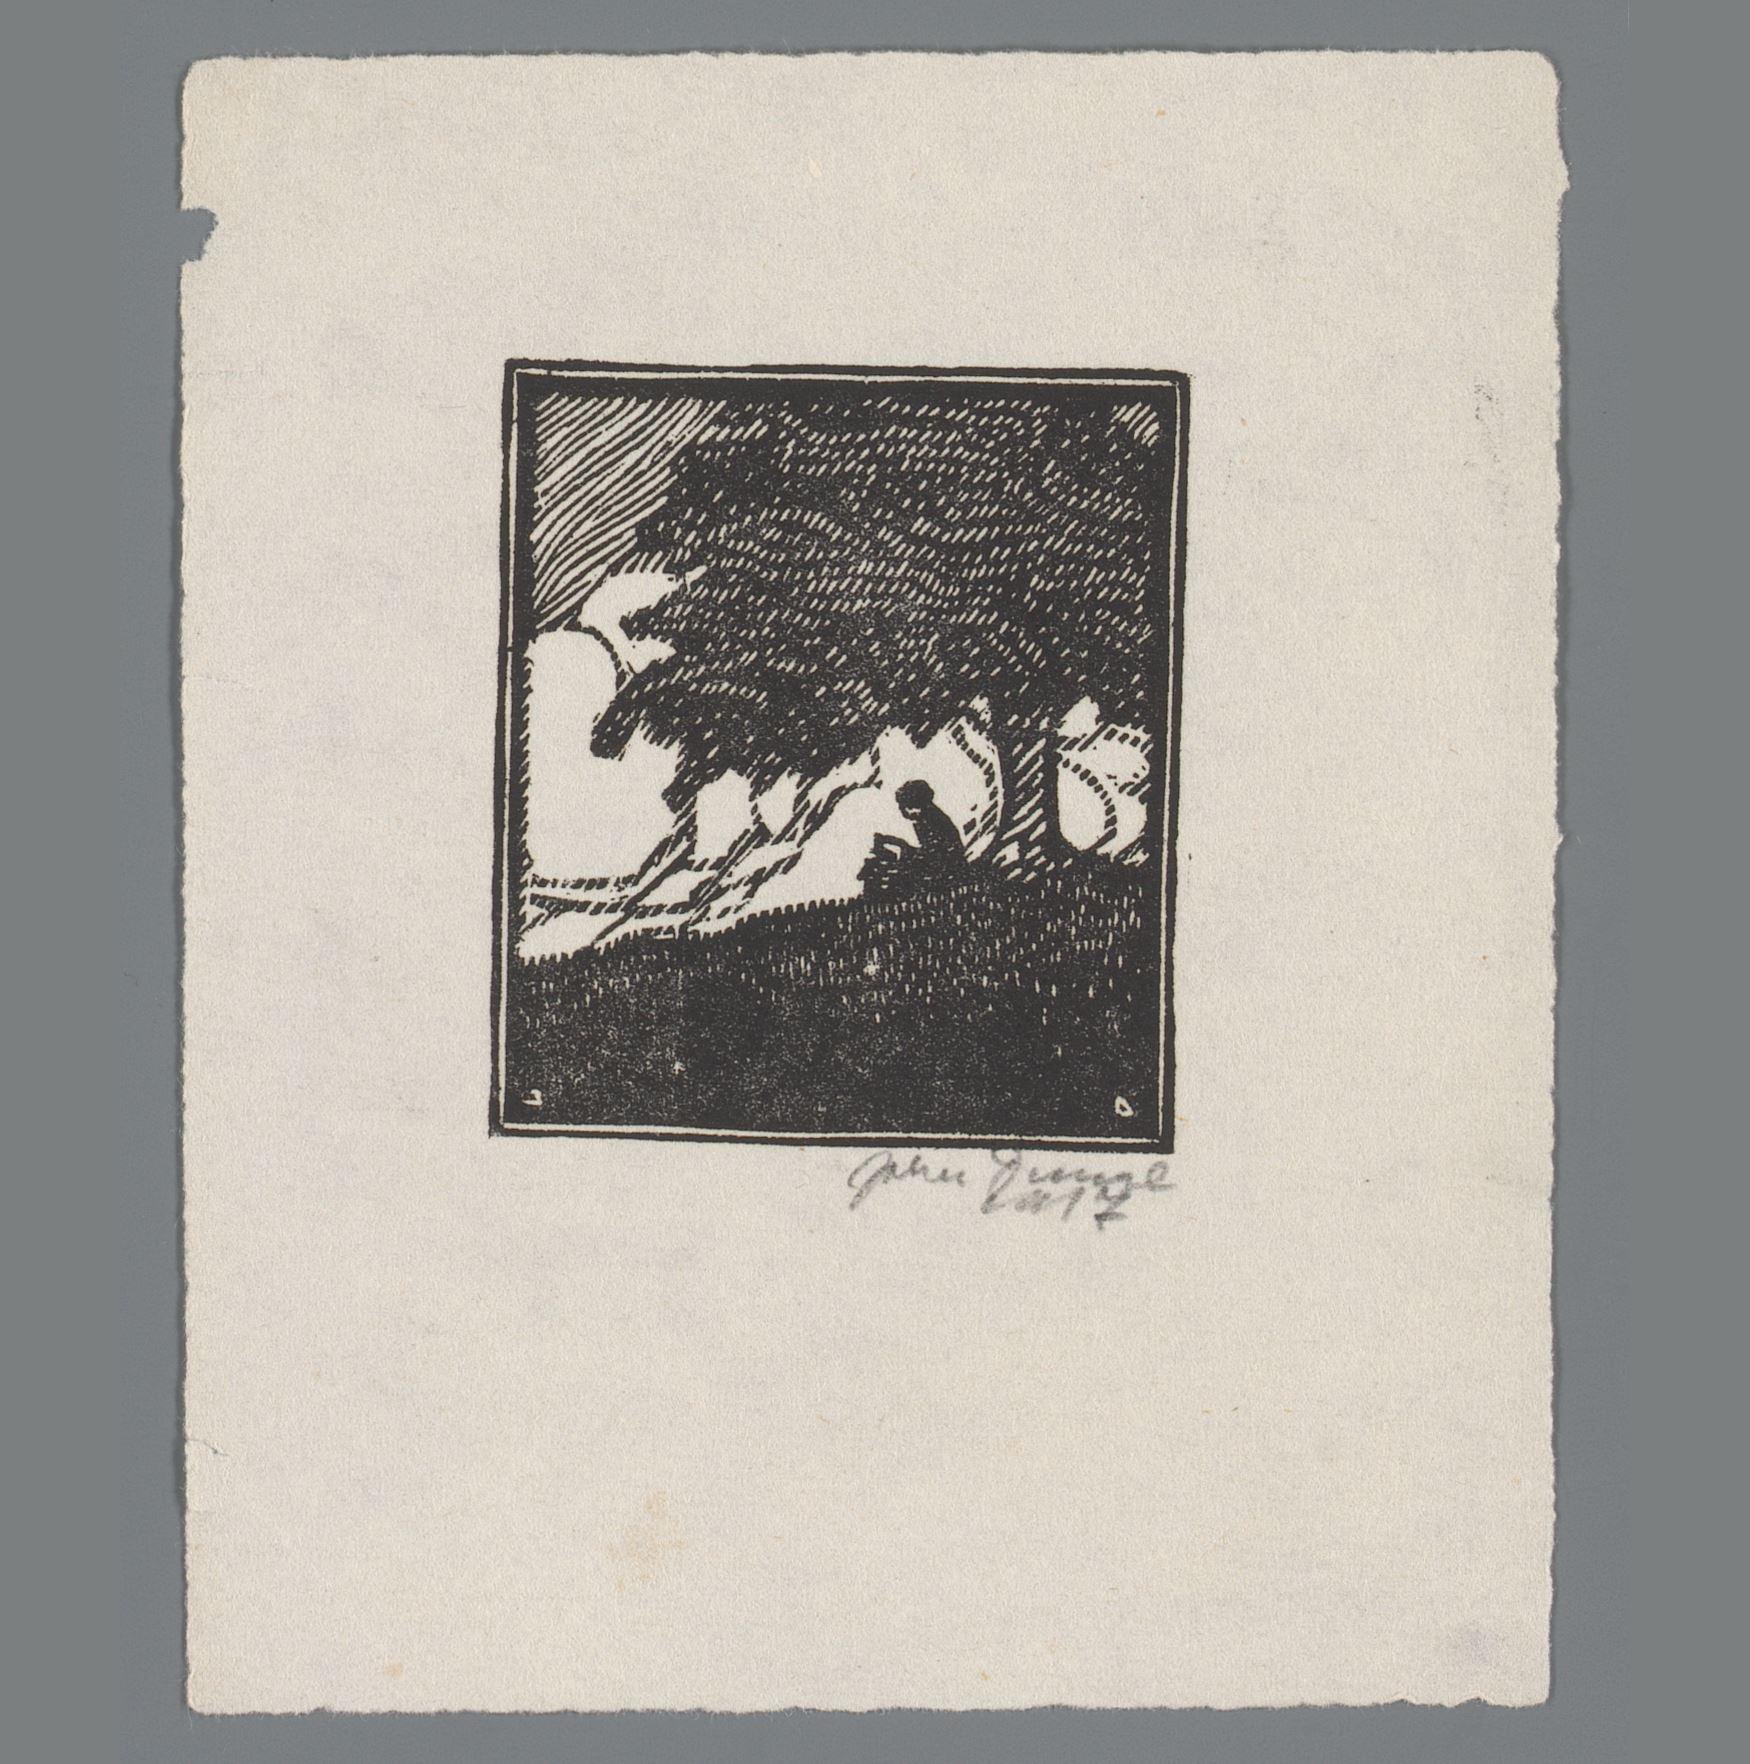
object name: print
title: Figuur zittend onder een boom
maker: john dunge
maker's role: graficus, houtsnijder, illustrator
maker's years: 1890-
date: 1917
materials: paper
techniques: woodcut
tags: trees, sitting on the ground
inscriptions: date